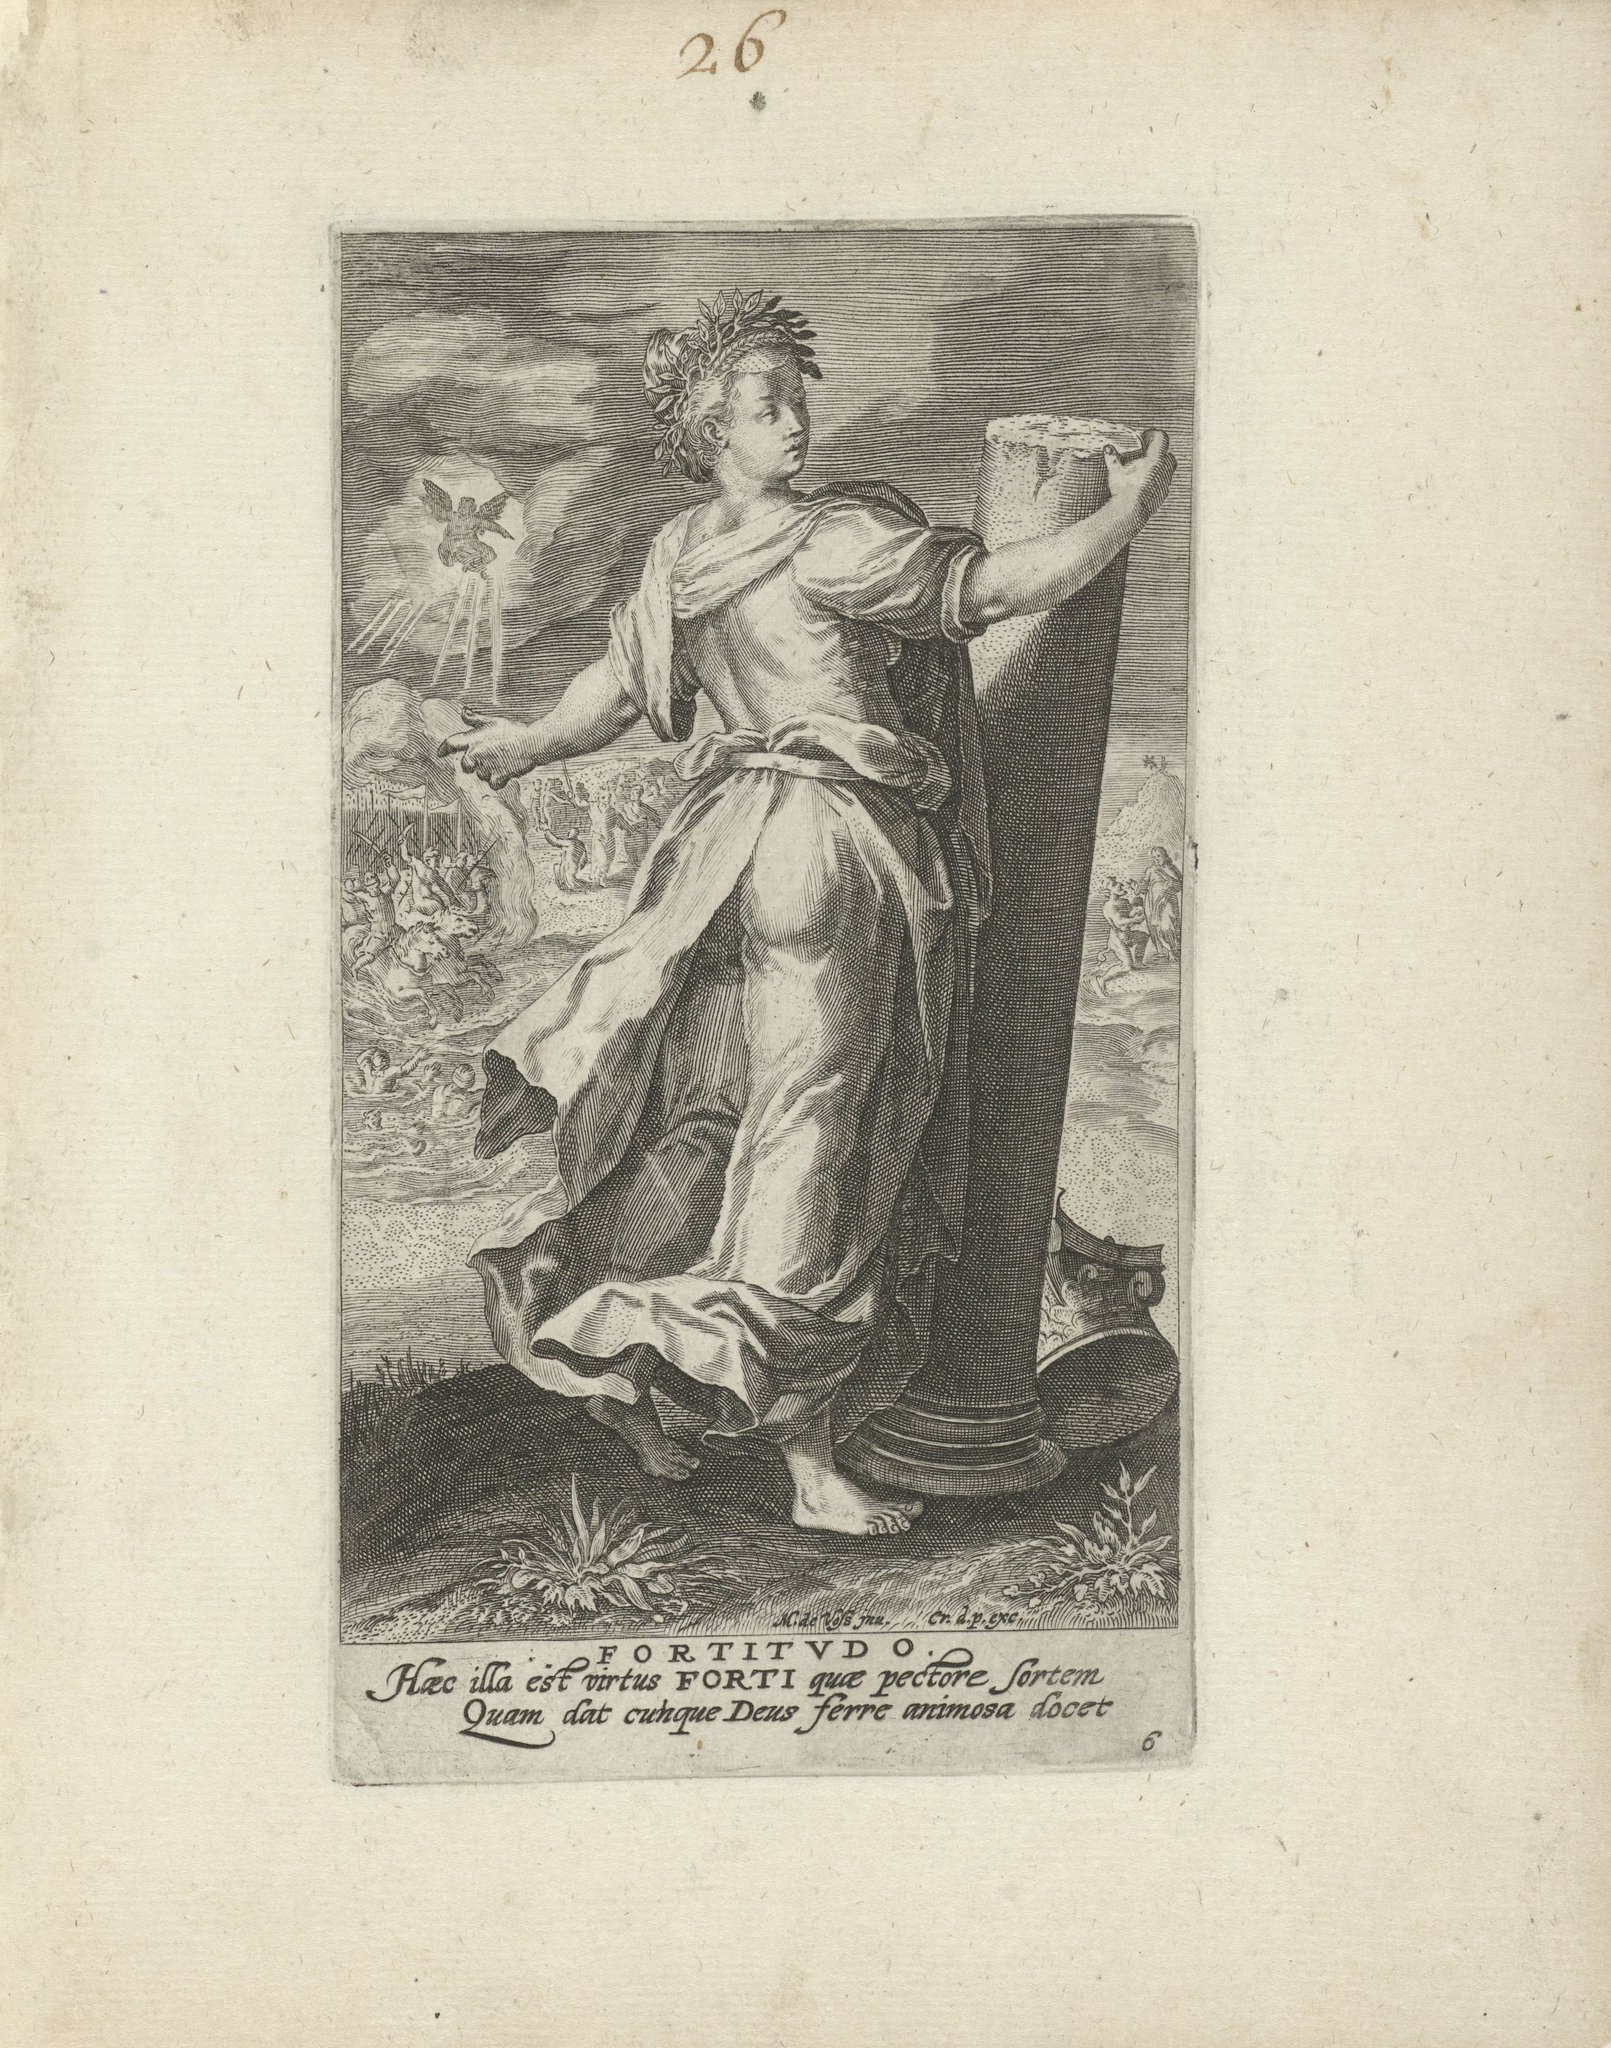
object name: print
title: Fortitvdo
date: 1580-1588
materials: paper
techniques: engraving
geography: antwerp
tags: fortitude, 'fortitudo' ~ one of the four cardinal virtues, christ, sometimes accompanied by guardian angel(s), tempted by satan, who usually appears in human form, with his people safe on the shore, moses raises his hands and causes the water to return; pharaoh's army perishes in the water (red sea)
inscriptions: number: ‘26’, collector's mark: Lugt 2228, collector's mark: Lugt 2760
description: Landschap met de vrouwelijke personificatie van Kracht (Fortitudo), een van de vier kardinale deugden, met een gebroken zuil. Links op de achtergrond overspoelt de Rode Zee farao en het Egyptische leger. Rechts op de achtergrond de verzoeking van Christus in de woestijn. In de marge een tweeregelig onderschrift in het Latijn. Zesde prent uit een serie met deugden.